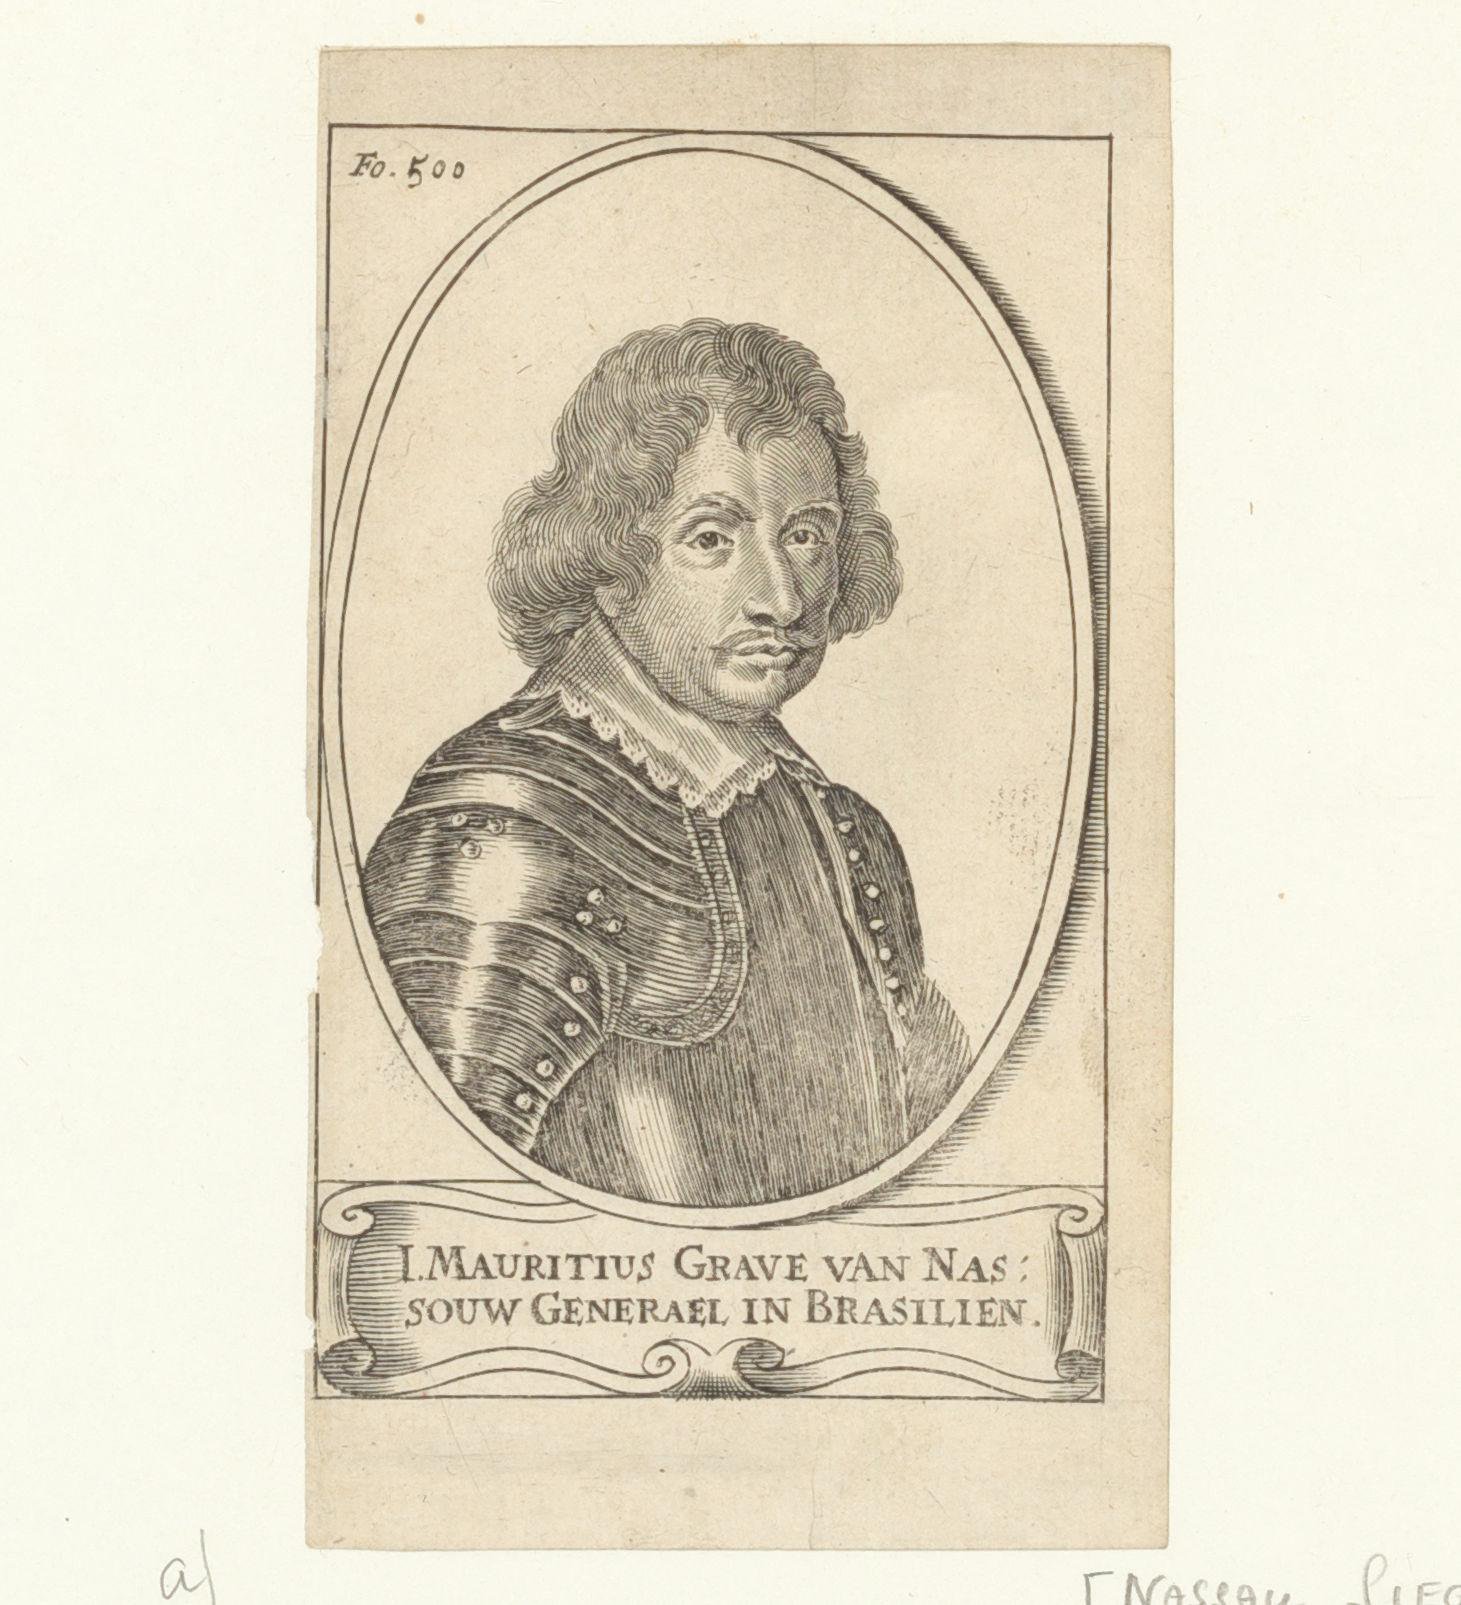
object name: print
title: Portret van Johan Maurits graaf van Nassau-Siegen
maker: Anonymous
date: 1651-1663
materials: paper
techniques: engraving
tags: earl, johan maurits graaf van nassau-siegen, colonial governor, historical persons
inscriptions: stamp, collector's mark: Lugt 1641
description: Prent mogelijk uit: Sande, Johan van den. De wakende leeuw der Nederlanden: historie (...). 2 Dln. Leeuwarden: Gysbert Sybes, 1651. Of uit: Sande, Johan van de. De wakende leeuw der Nederlanden Historie (...). Leeuwarden: Gysbert Sybes, 1658. Of uit: Sande, Johan van den. De wakende leeuw der Nederlanden: historie (...). 2 Dln. Amsterdam: Gerrit van Goedesbergh, 1663, dl. 1.